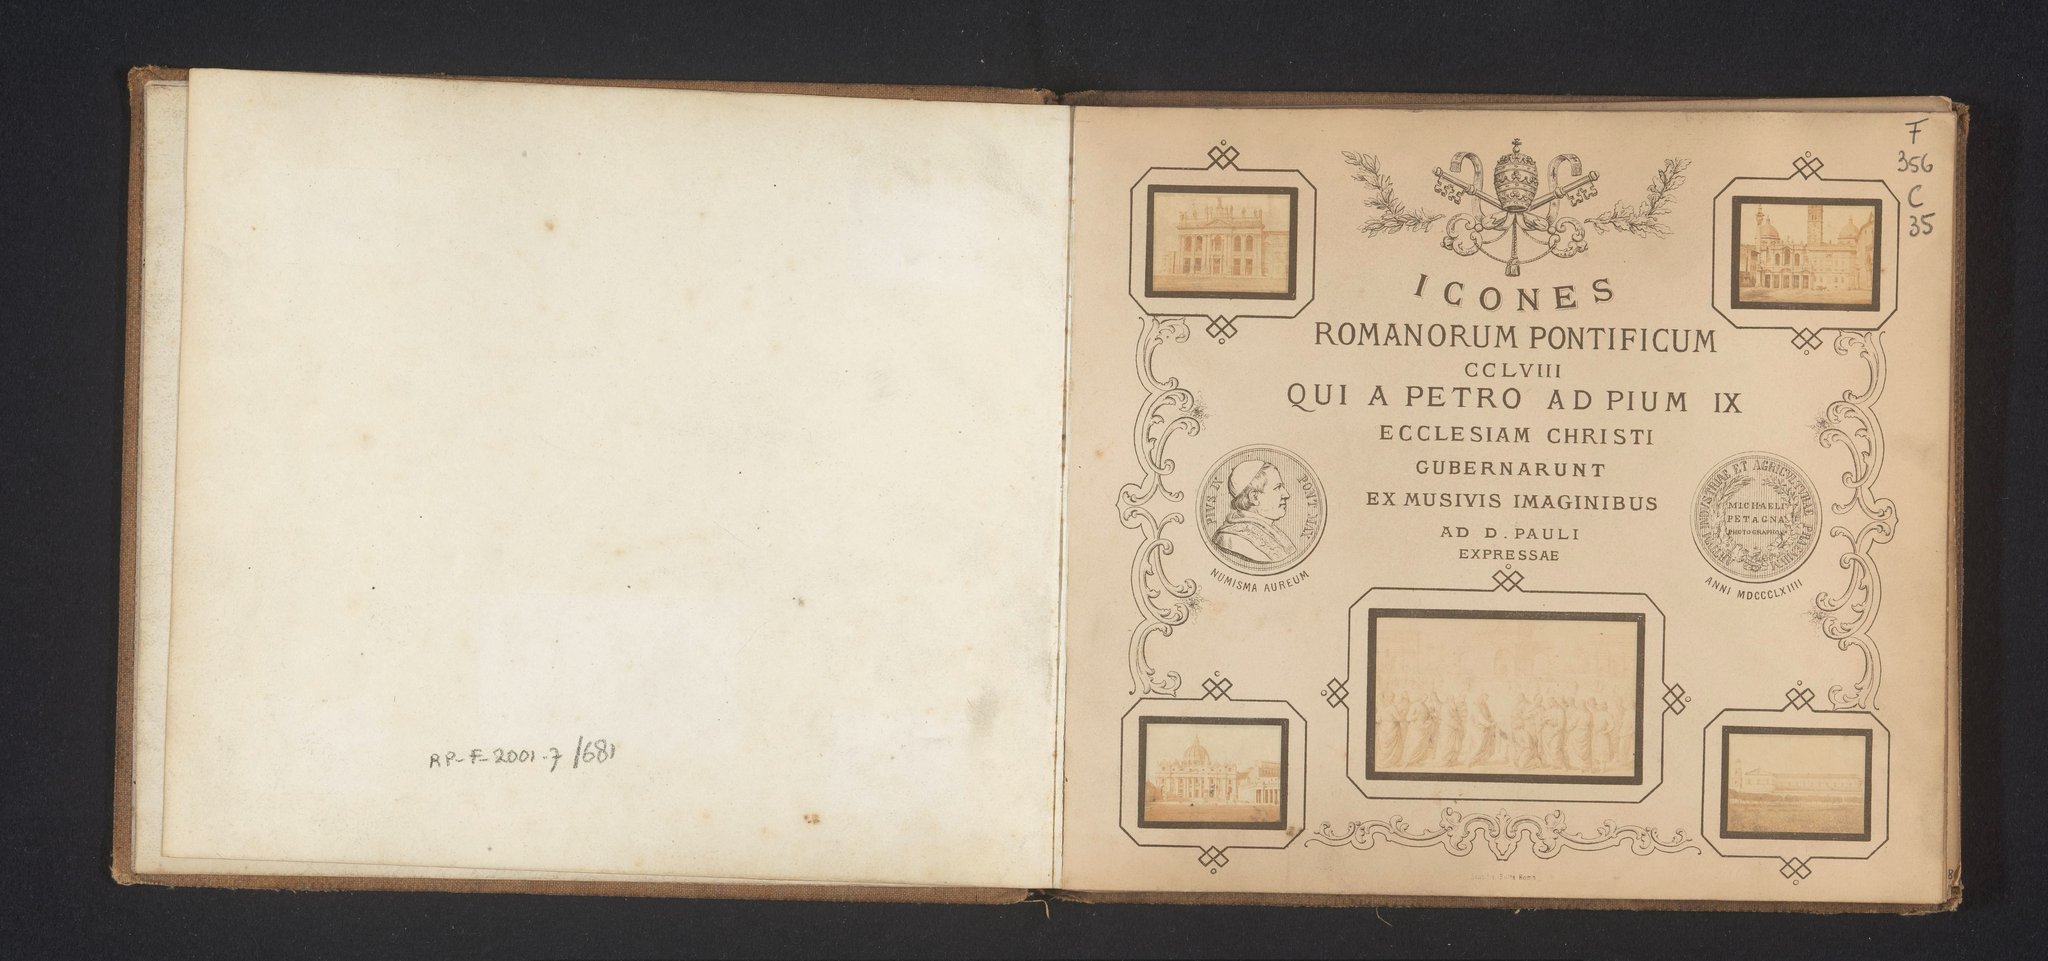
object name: reproduction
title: Vier vermoedelijk kerkelijke gebouwen en een fotoreproductie van een afbeelding van Christus met een man aan zijn voeten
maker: m. petagna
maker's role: fotograaf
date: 1854-1864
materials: photographic support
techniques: albumen print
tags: church (exterior), façade (of house or building)